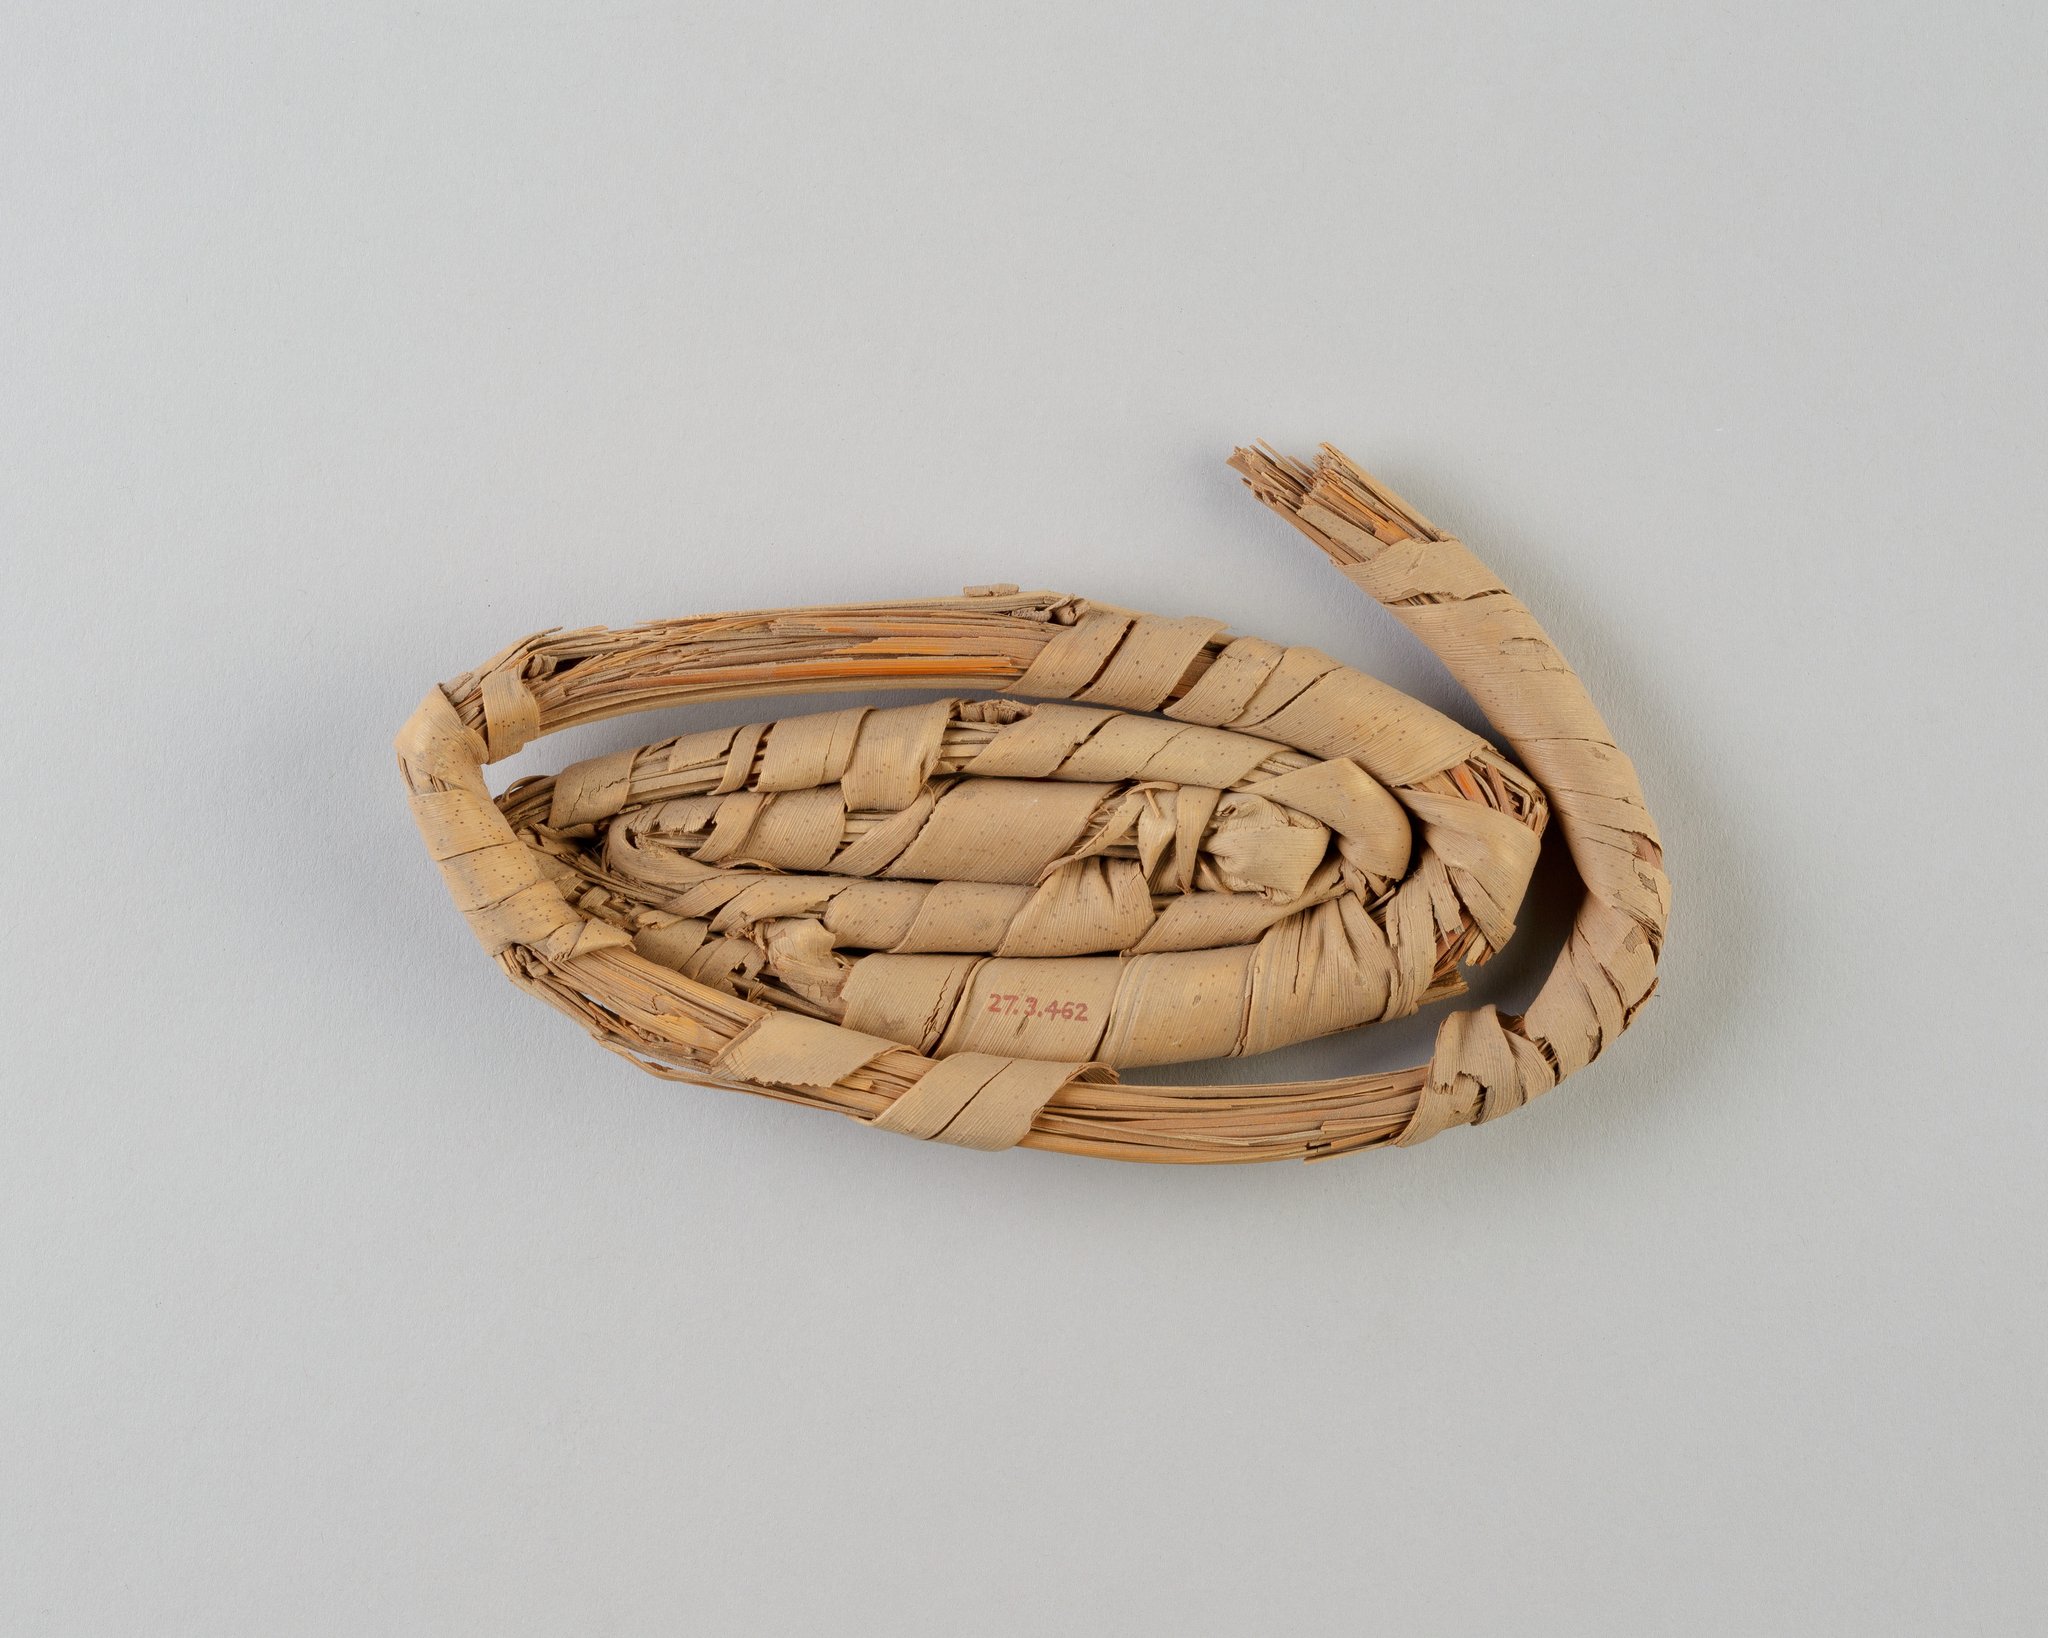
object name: basketry, model, senenmut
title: Tray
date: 1479-1458 BCE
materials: leaf, fiber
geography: egypt